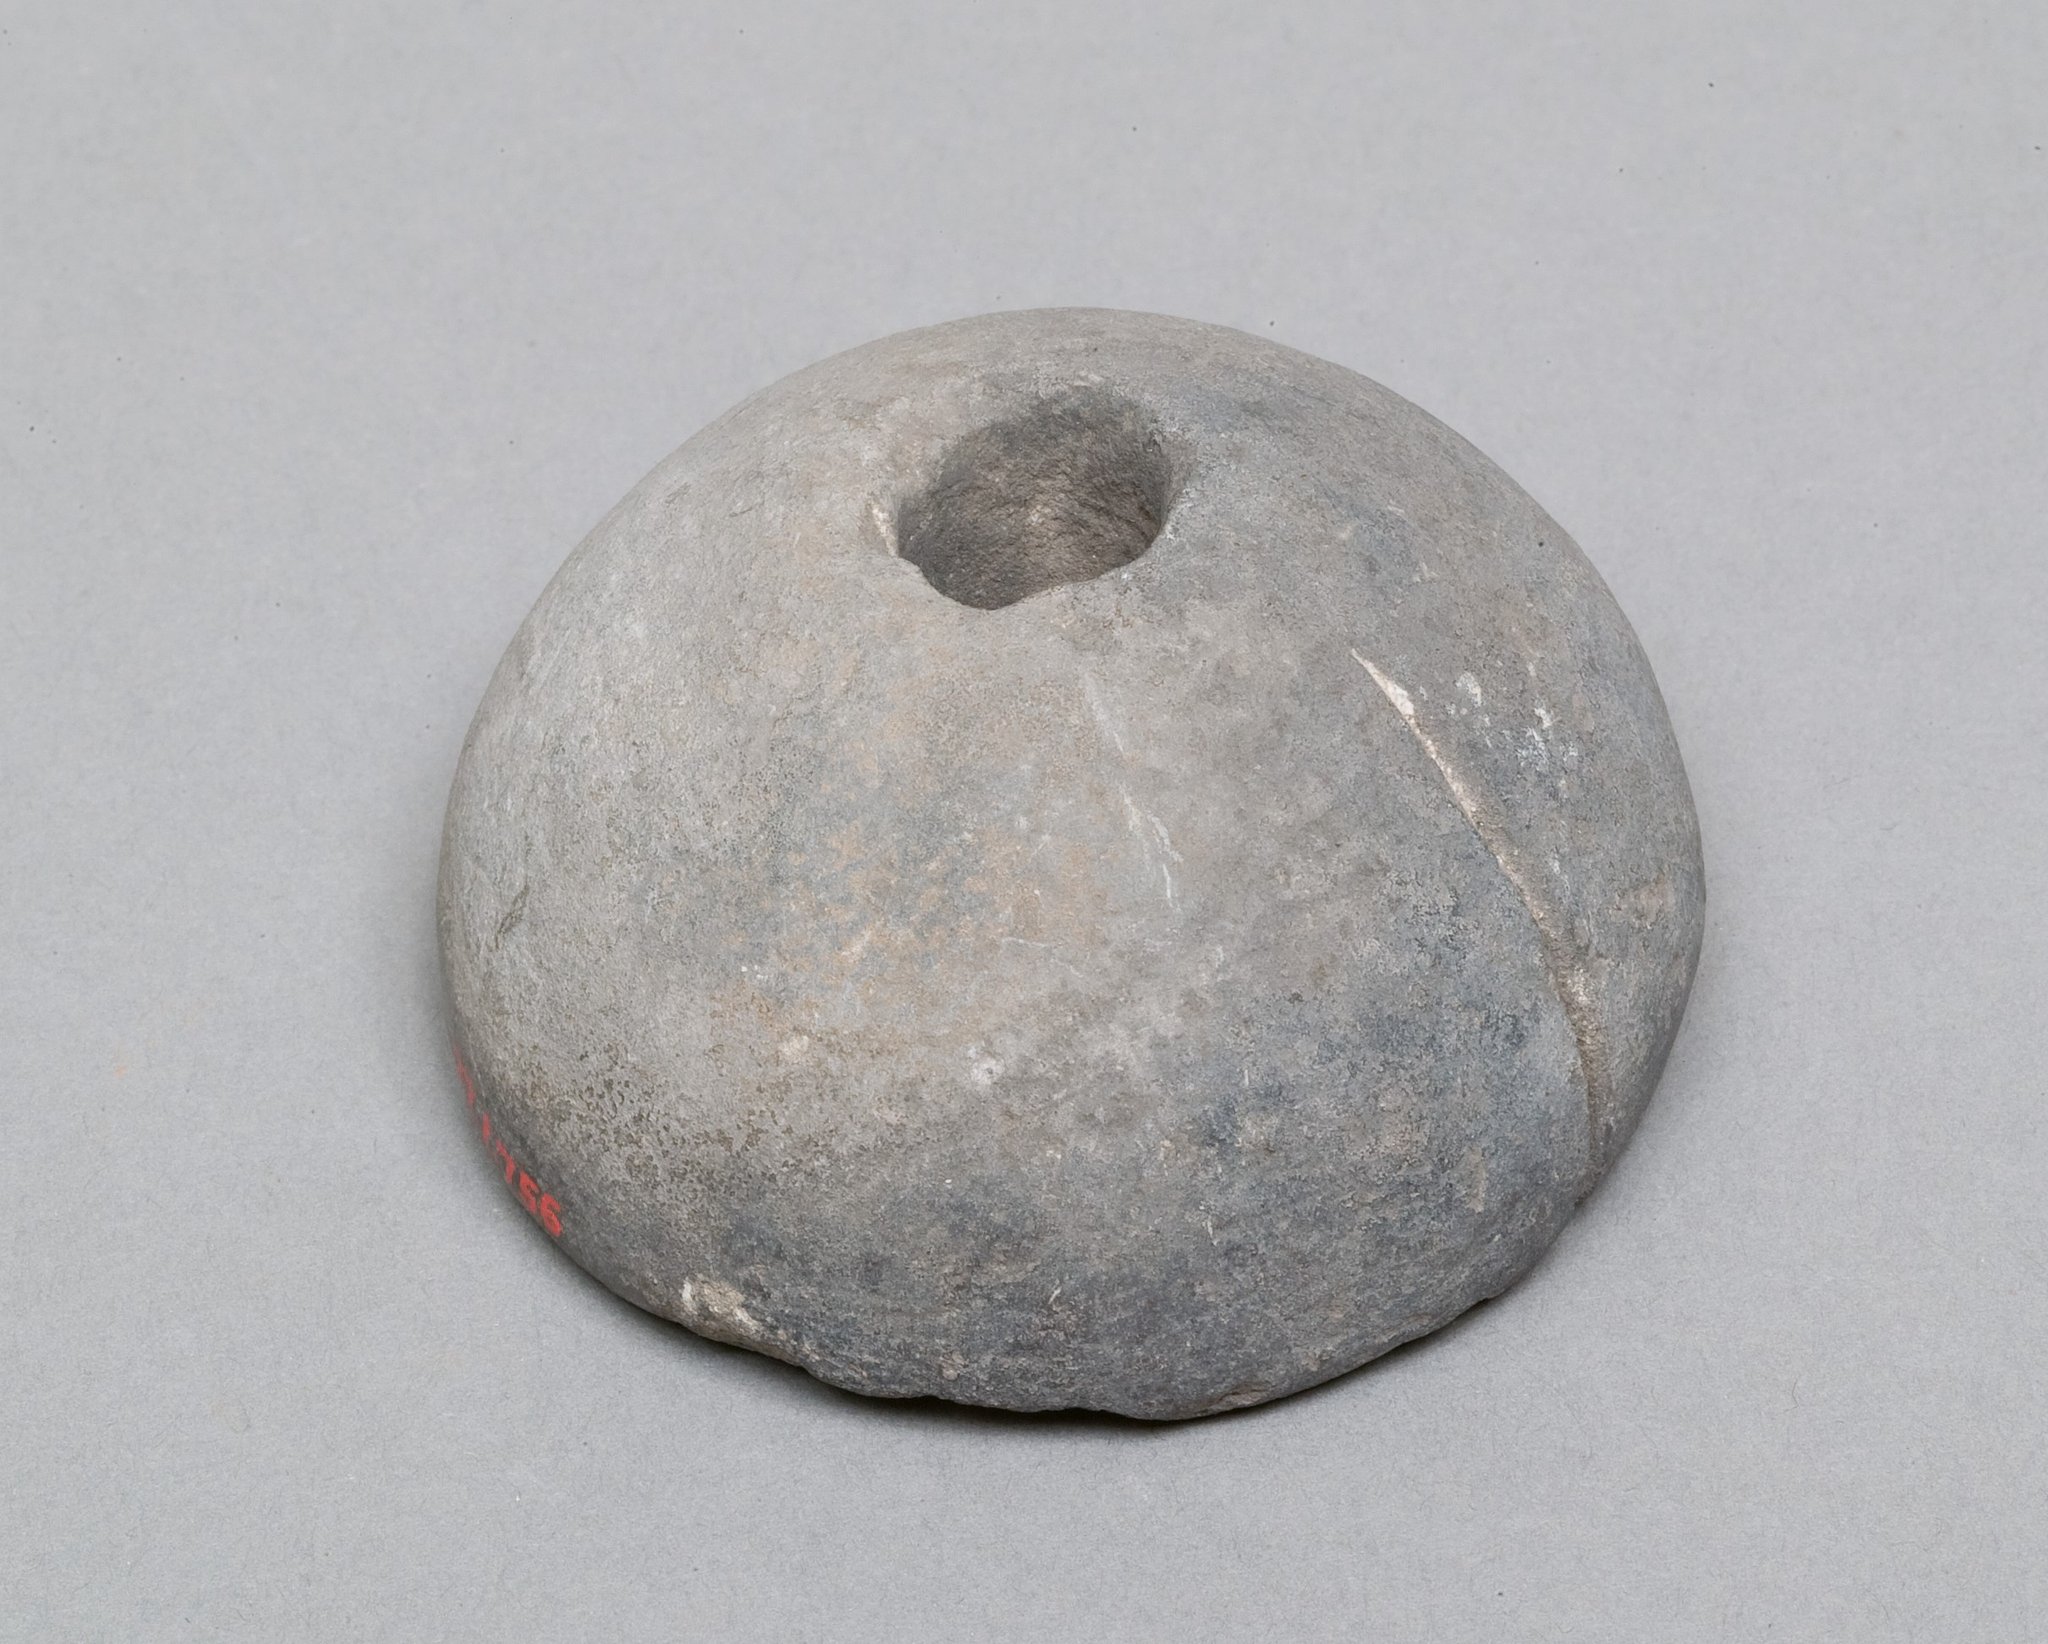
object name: spindle whorl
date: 1295-1070 BCE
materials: clay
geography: egypt